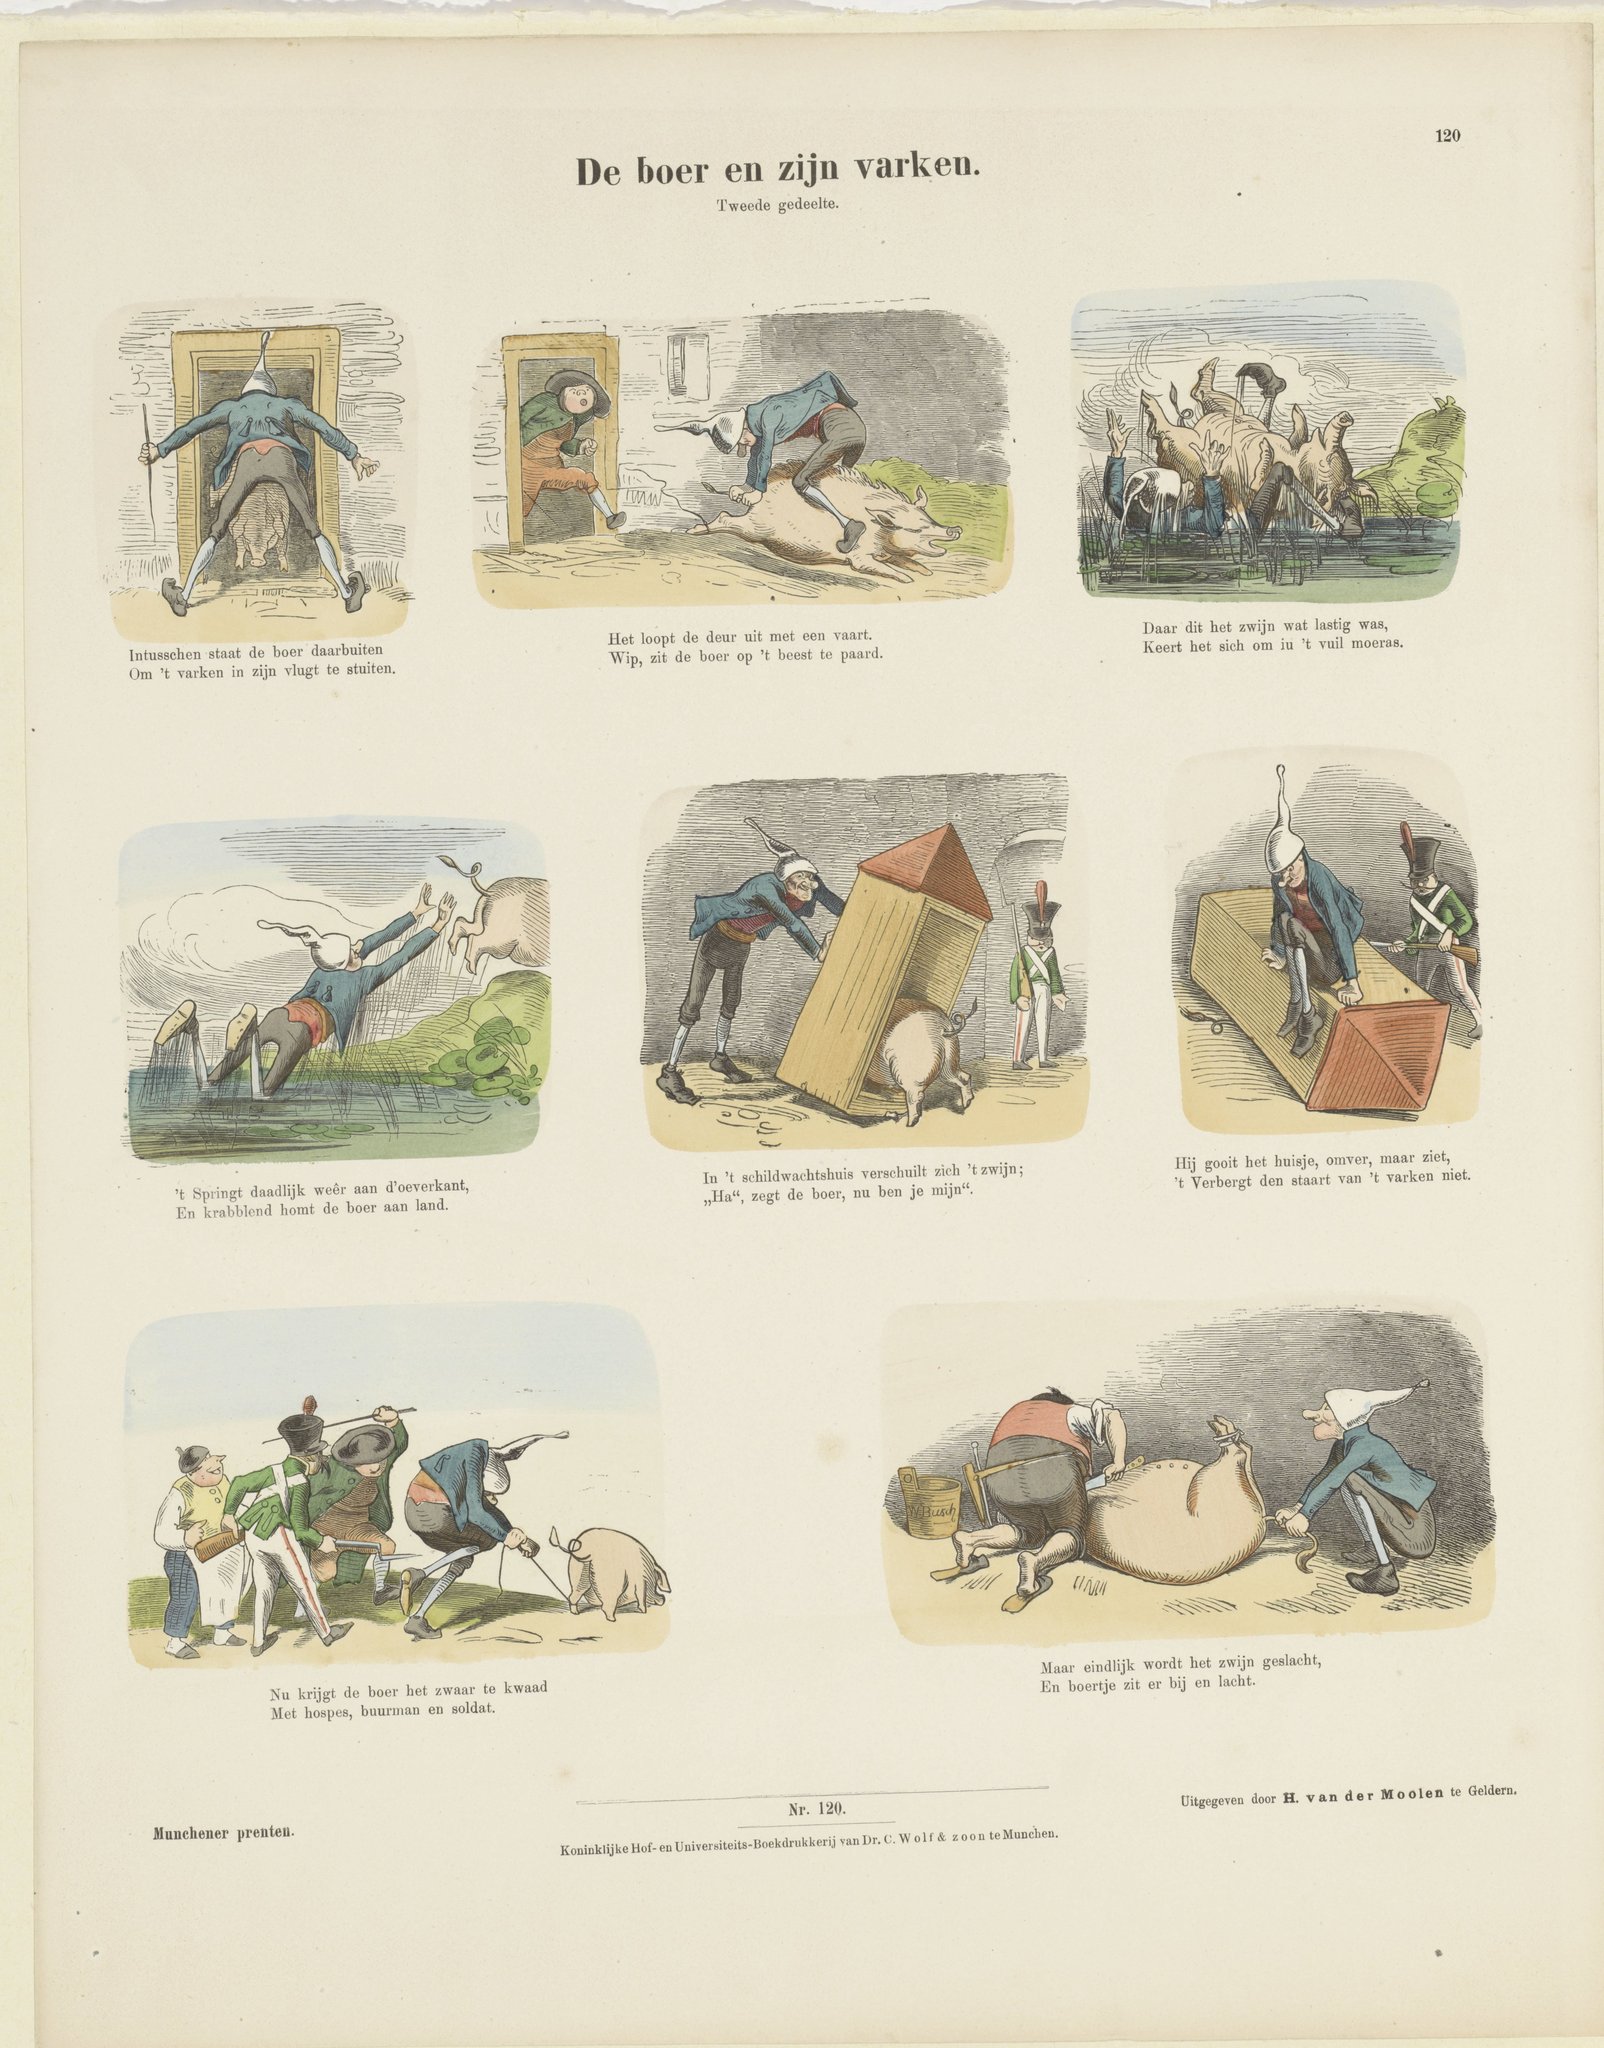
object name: popular print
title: Munchener platen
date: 1843-1920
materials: paper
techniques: colour, letterpress printing, engraving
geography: munich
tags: pig, farmers, slaughtered ox or pig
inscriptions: collector's mark: Lugt 2760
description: Blad met 8 voorstellingen van een boer die een varken vangt en doodt. Onder elke afbeelding een tweeregelig vers. Genummerd midden onder: Nro. 120. Genummerd rechtsboven: 120.